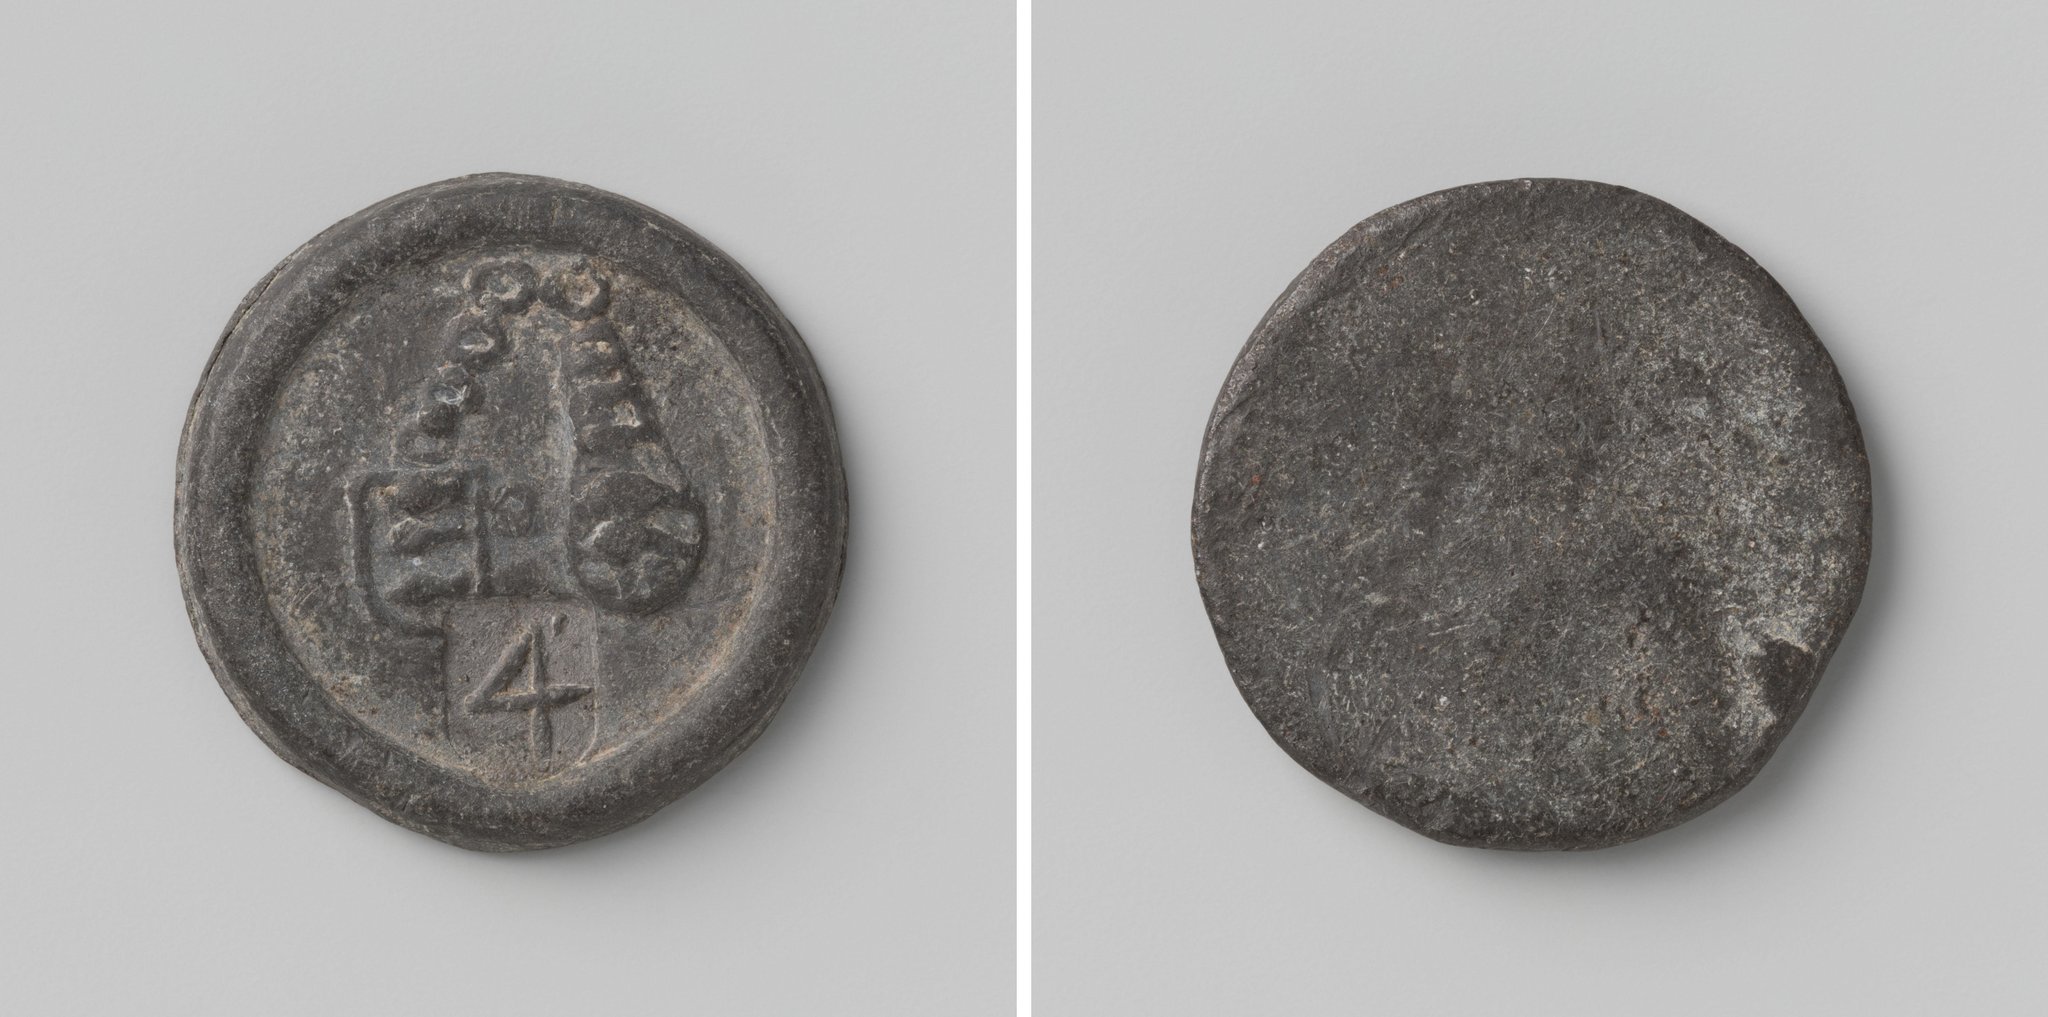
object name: bakenlood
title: Stad Enkhuizen, loodje met cijfer 4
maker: Anonymous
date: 1600-1800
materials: lead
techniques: striking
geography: enkhuizen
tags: enkhuizen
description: eenzijdig loodje. Voorzijde: stempel en wapenschild boven compartiment met cijfer 4. Keerzijde: blanco